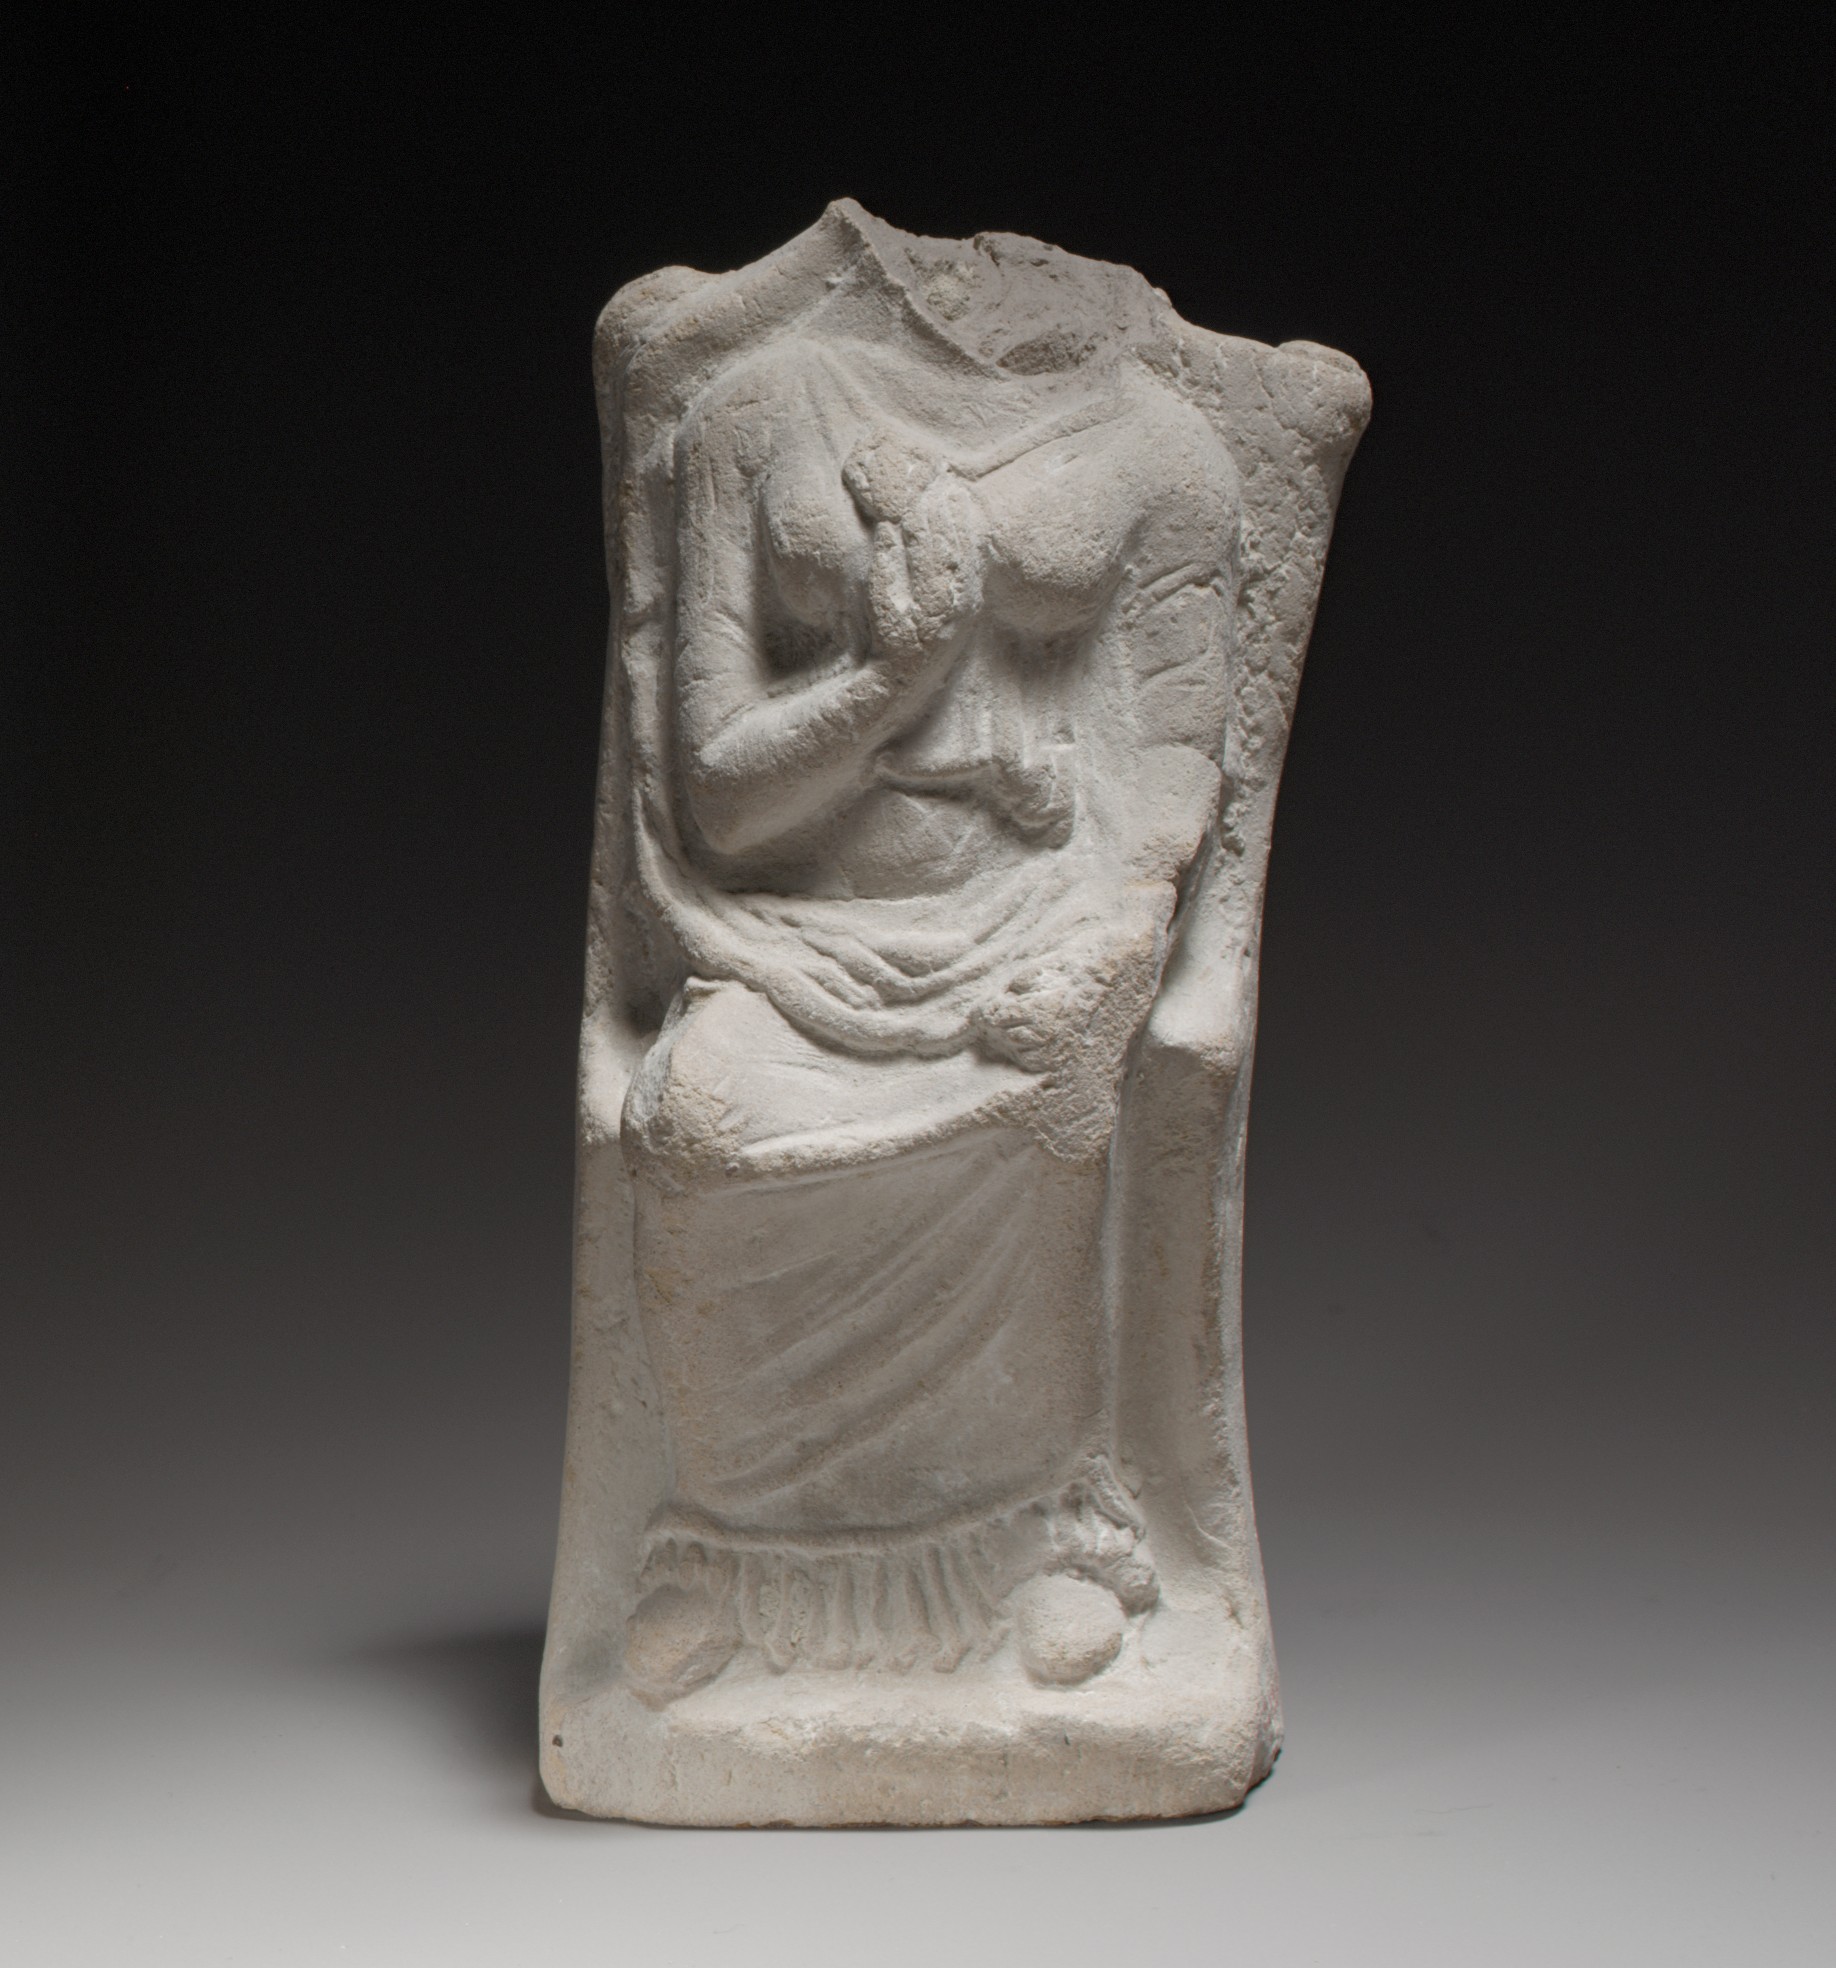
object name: statuette of a seated goddess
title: Terracotta statuette of a seated goddess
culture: cypriot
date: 300-201 BCE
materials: terracotta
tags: goddess